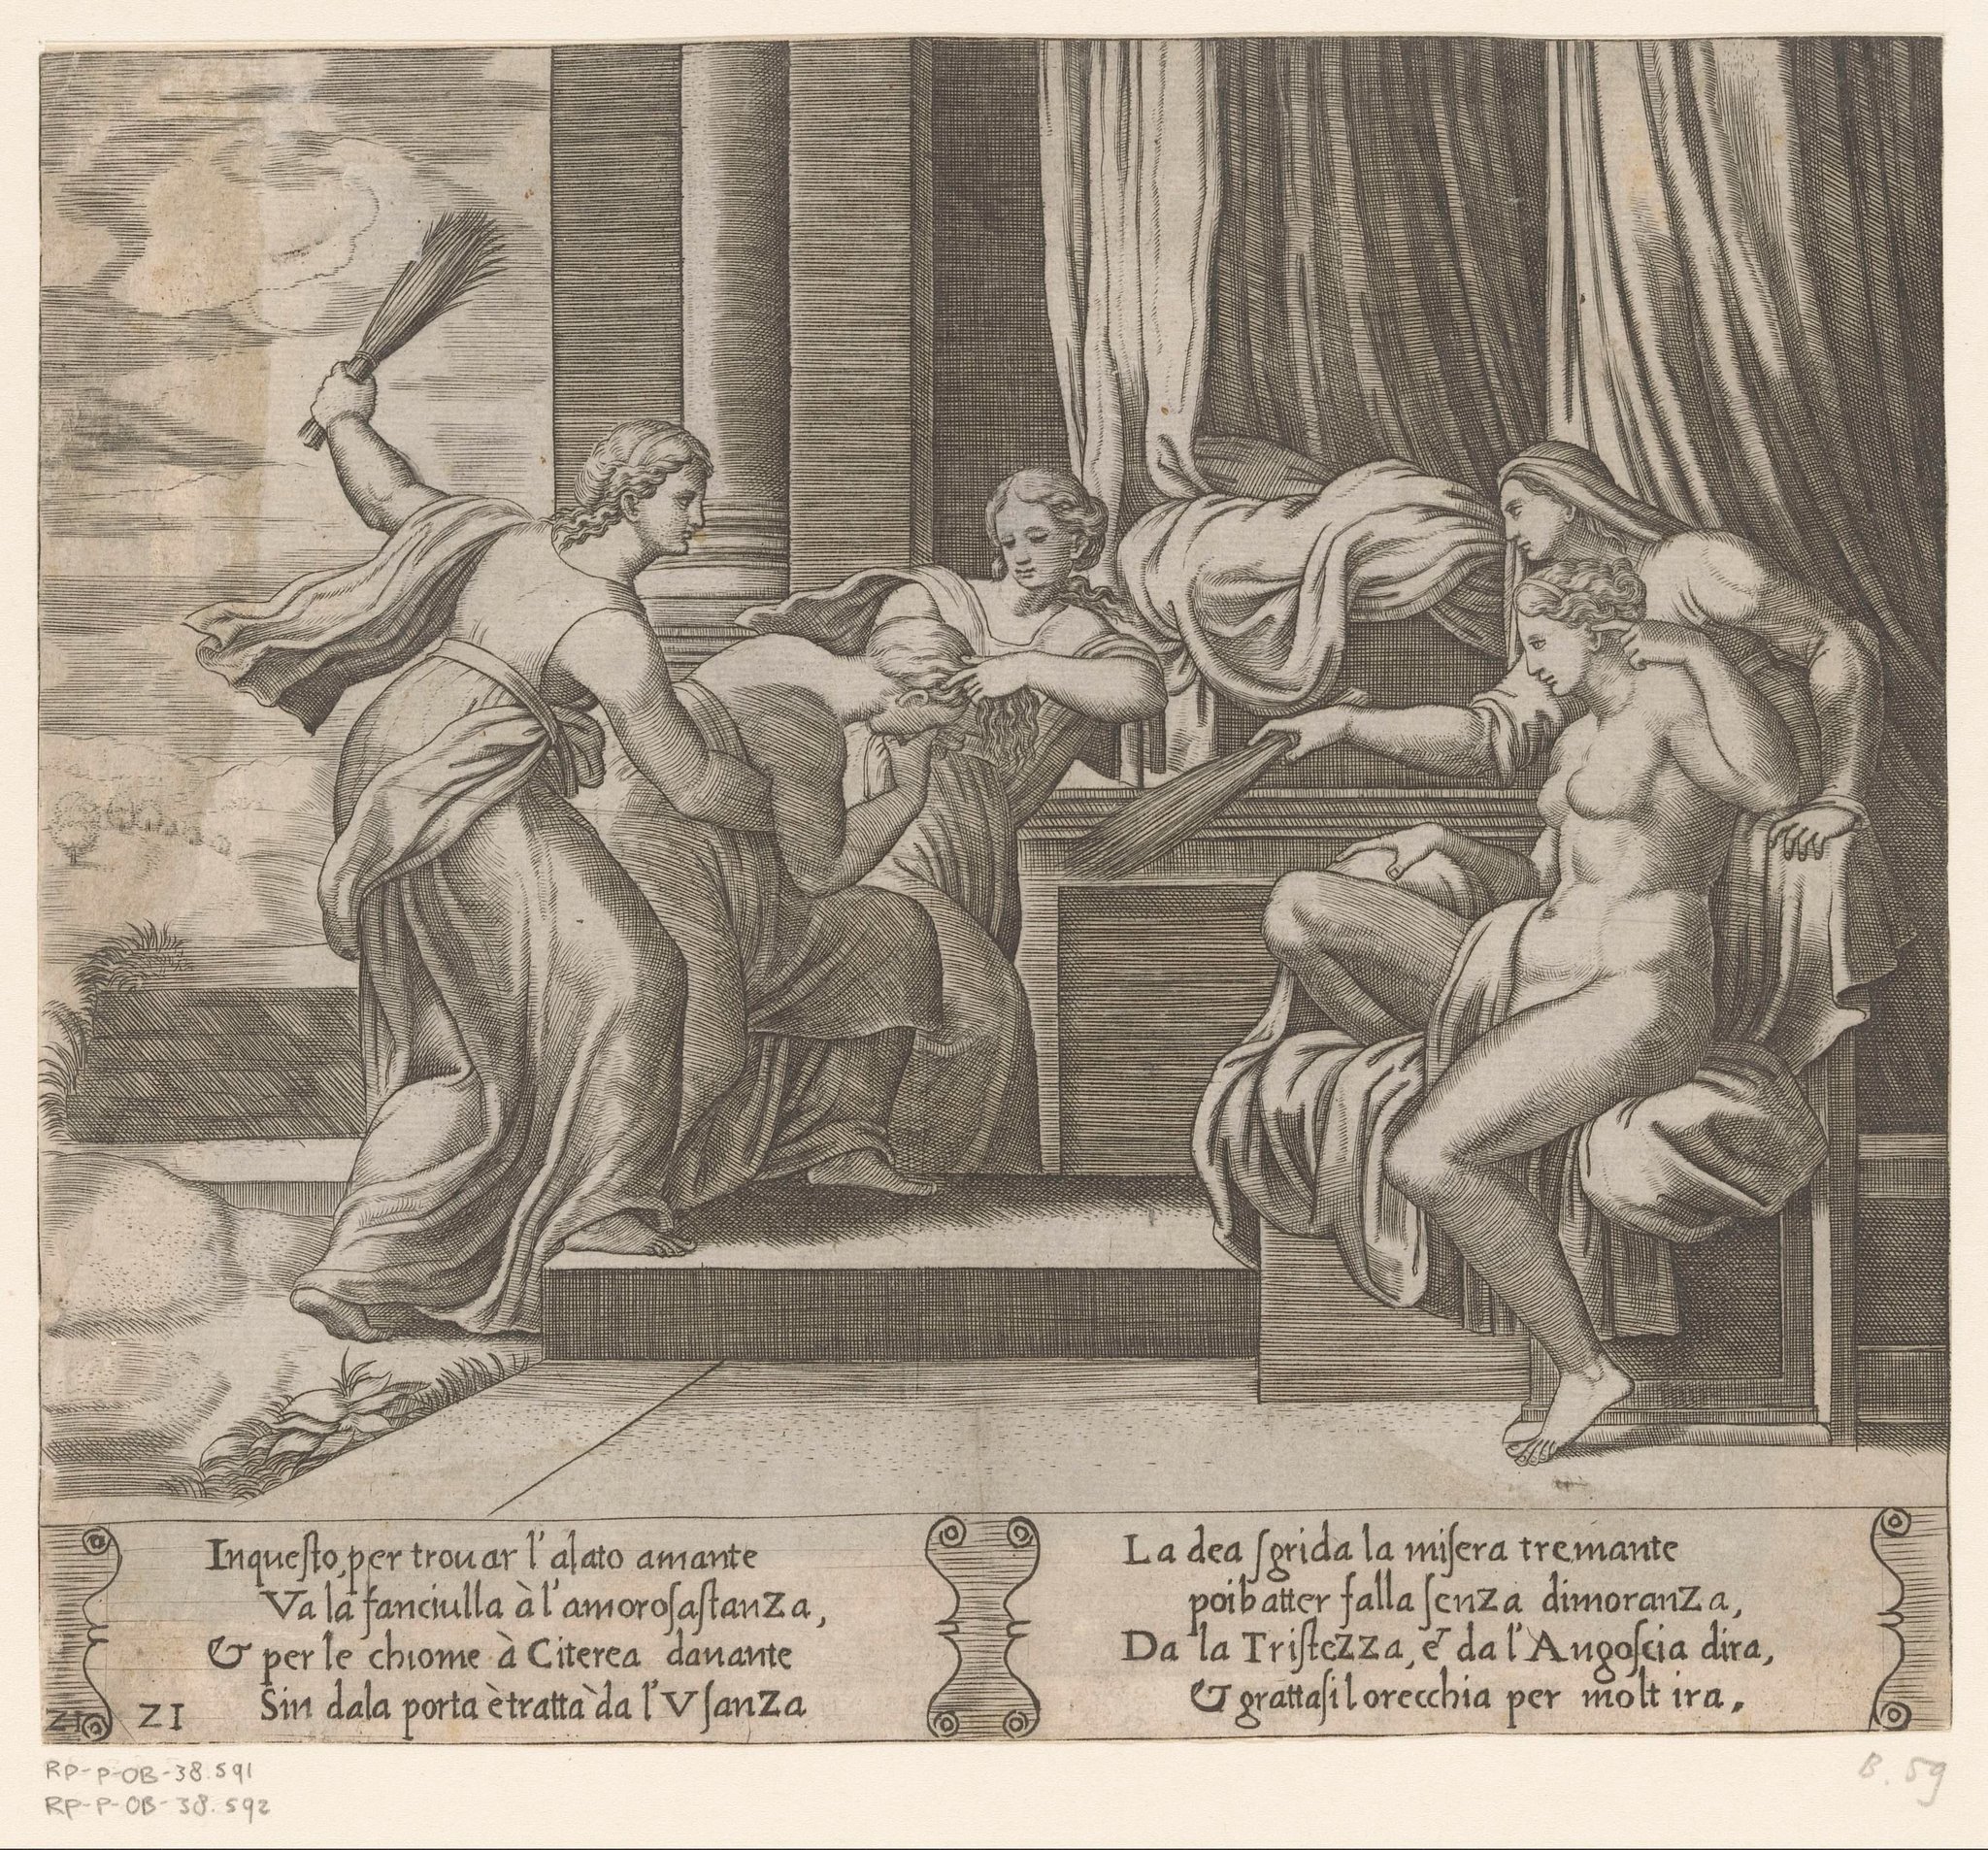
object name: print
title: Verhaal van Amor en Psyche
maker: meester van de dobbelsteen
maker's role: print maker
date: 1530-1560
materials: paper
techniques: engraving, intaglio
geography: italy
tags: pain, sorrow, sadness; 'dolore', 'dolore di zeusi' (ripa), other scenes from the story of cupid and psyche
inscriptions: collector's mark: Lugt 2228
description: De personificaties van smart en pijn straffen Psyche in opdracht van de godin Venus. Venus zit rechts op een stoel en kijkt toe. Italiaanse tekst in twee cartouches in ondermarge. Tweemaal genummerd linksonder: 21.